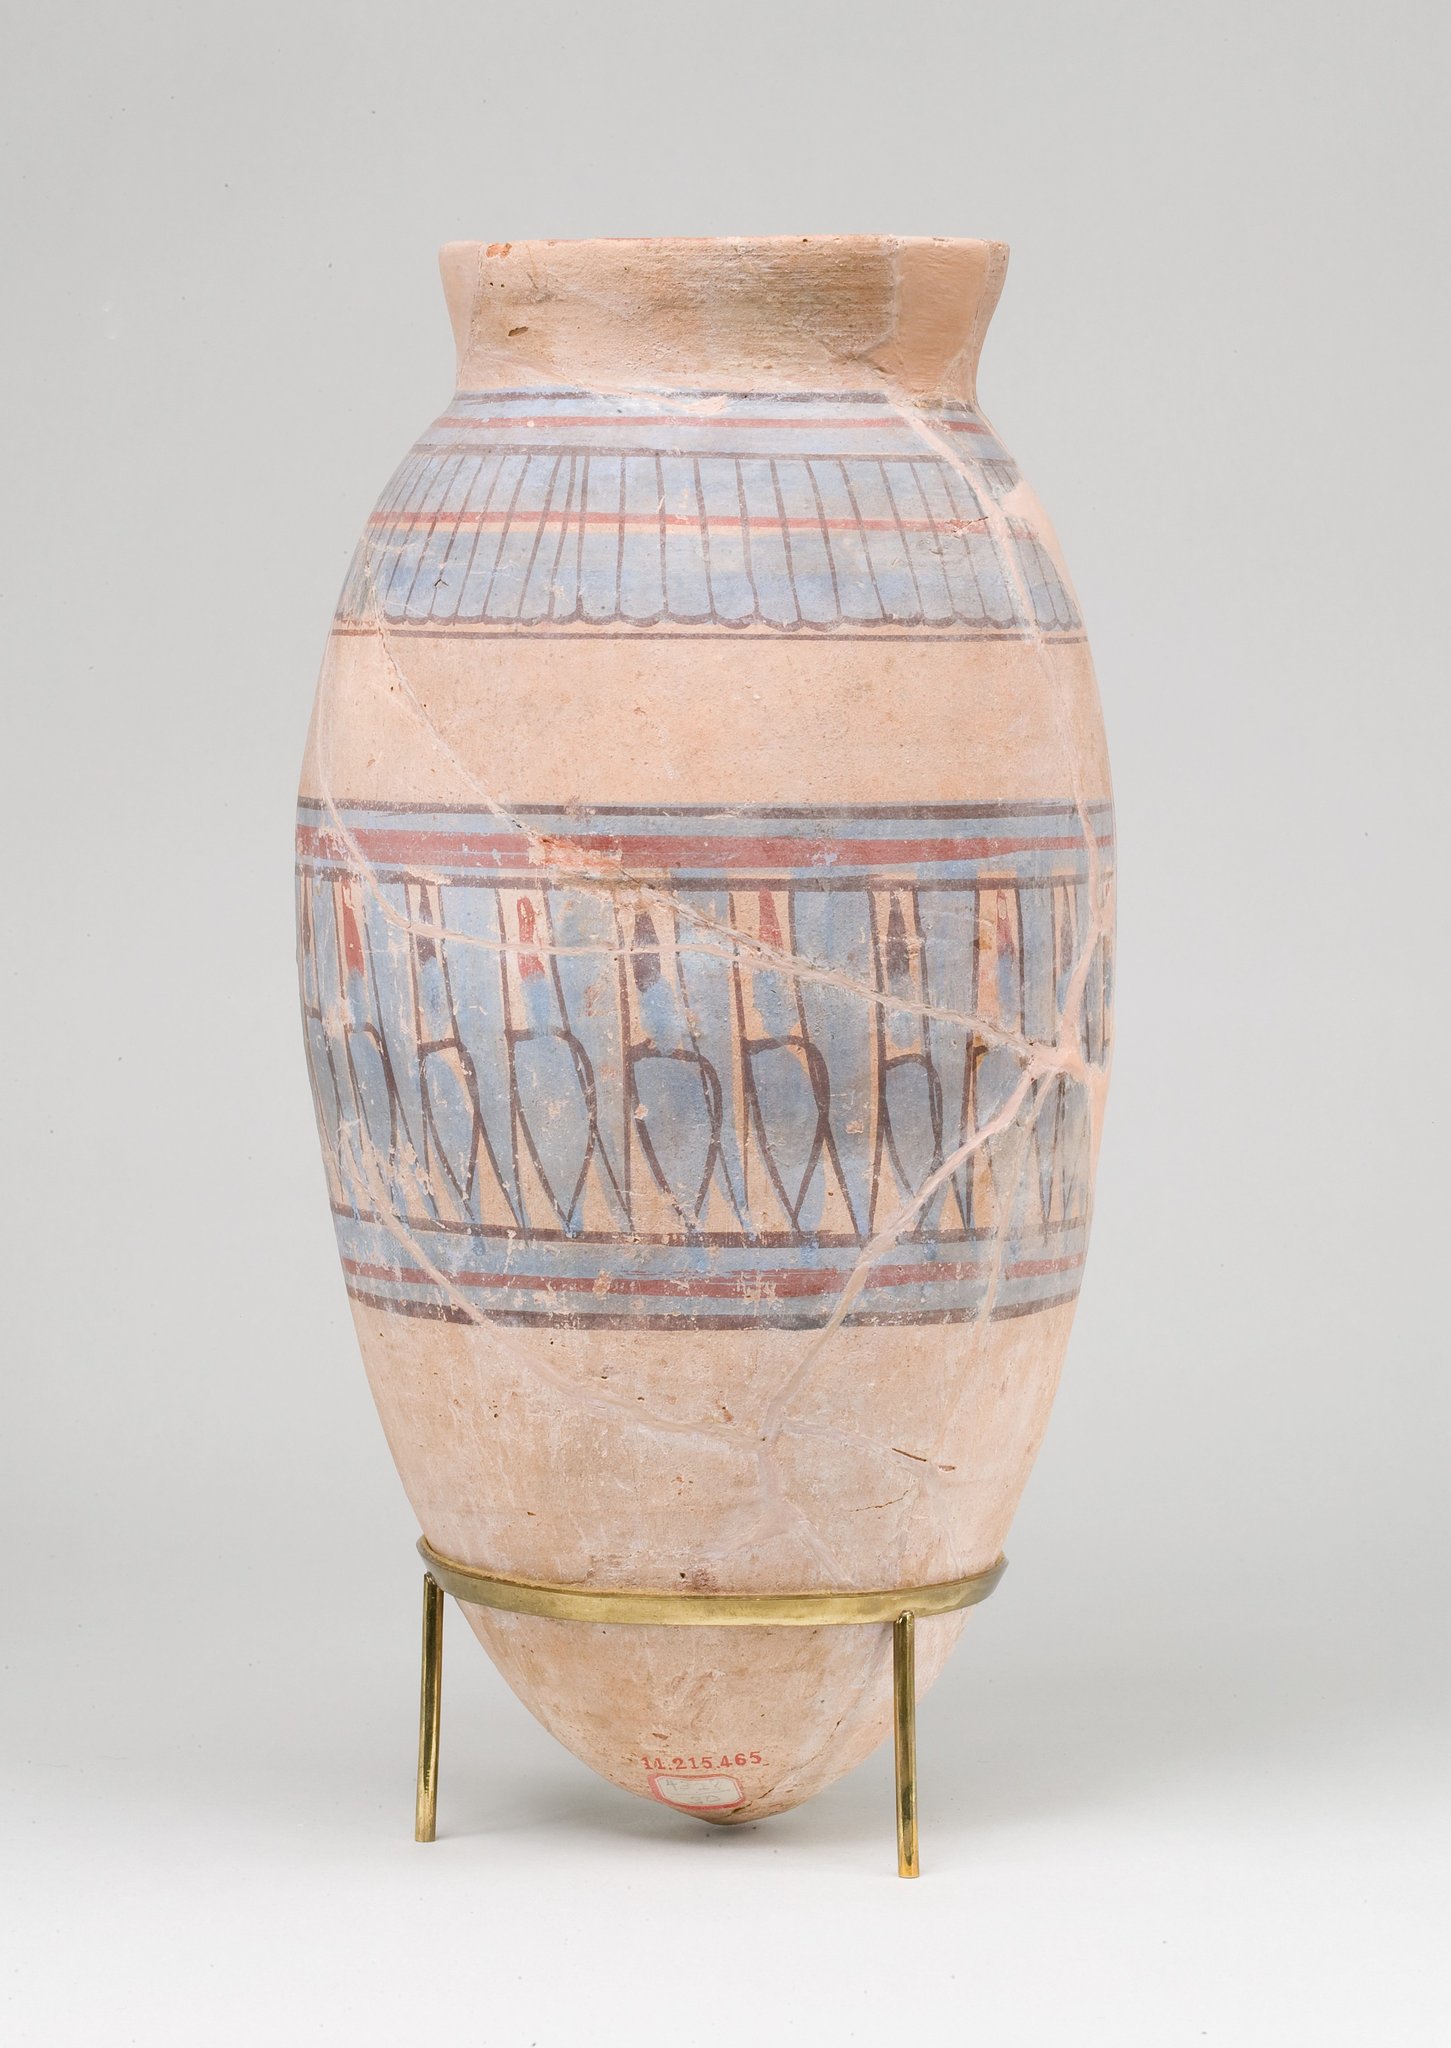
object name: jar, blue painted ware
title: Blue-painted Jar from Malqata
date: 1390-1352 BCE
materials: paint, pottery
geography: egypt